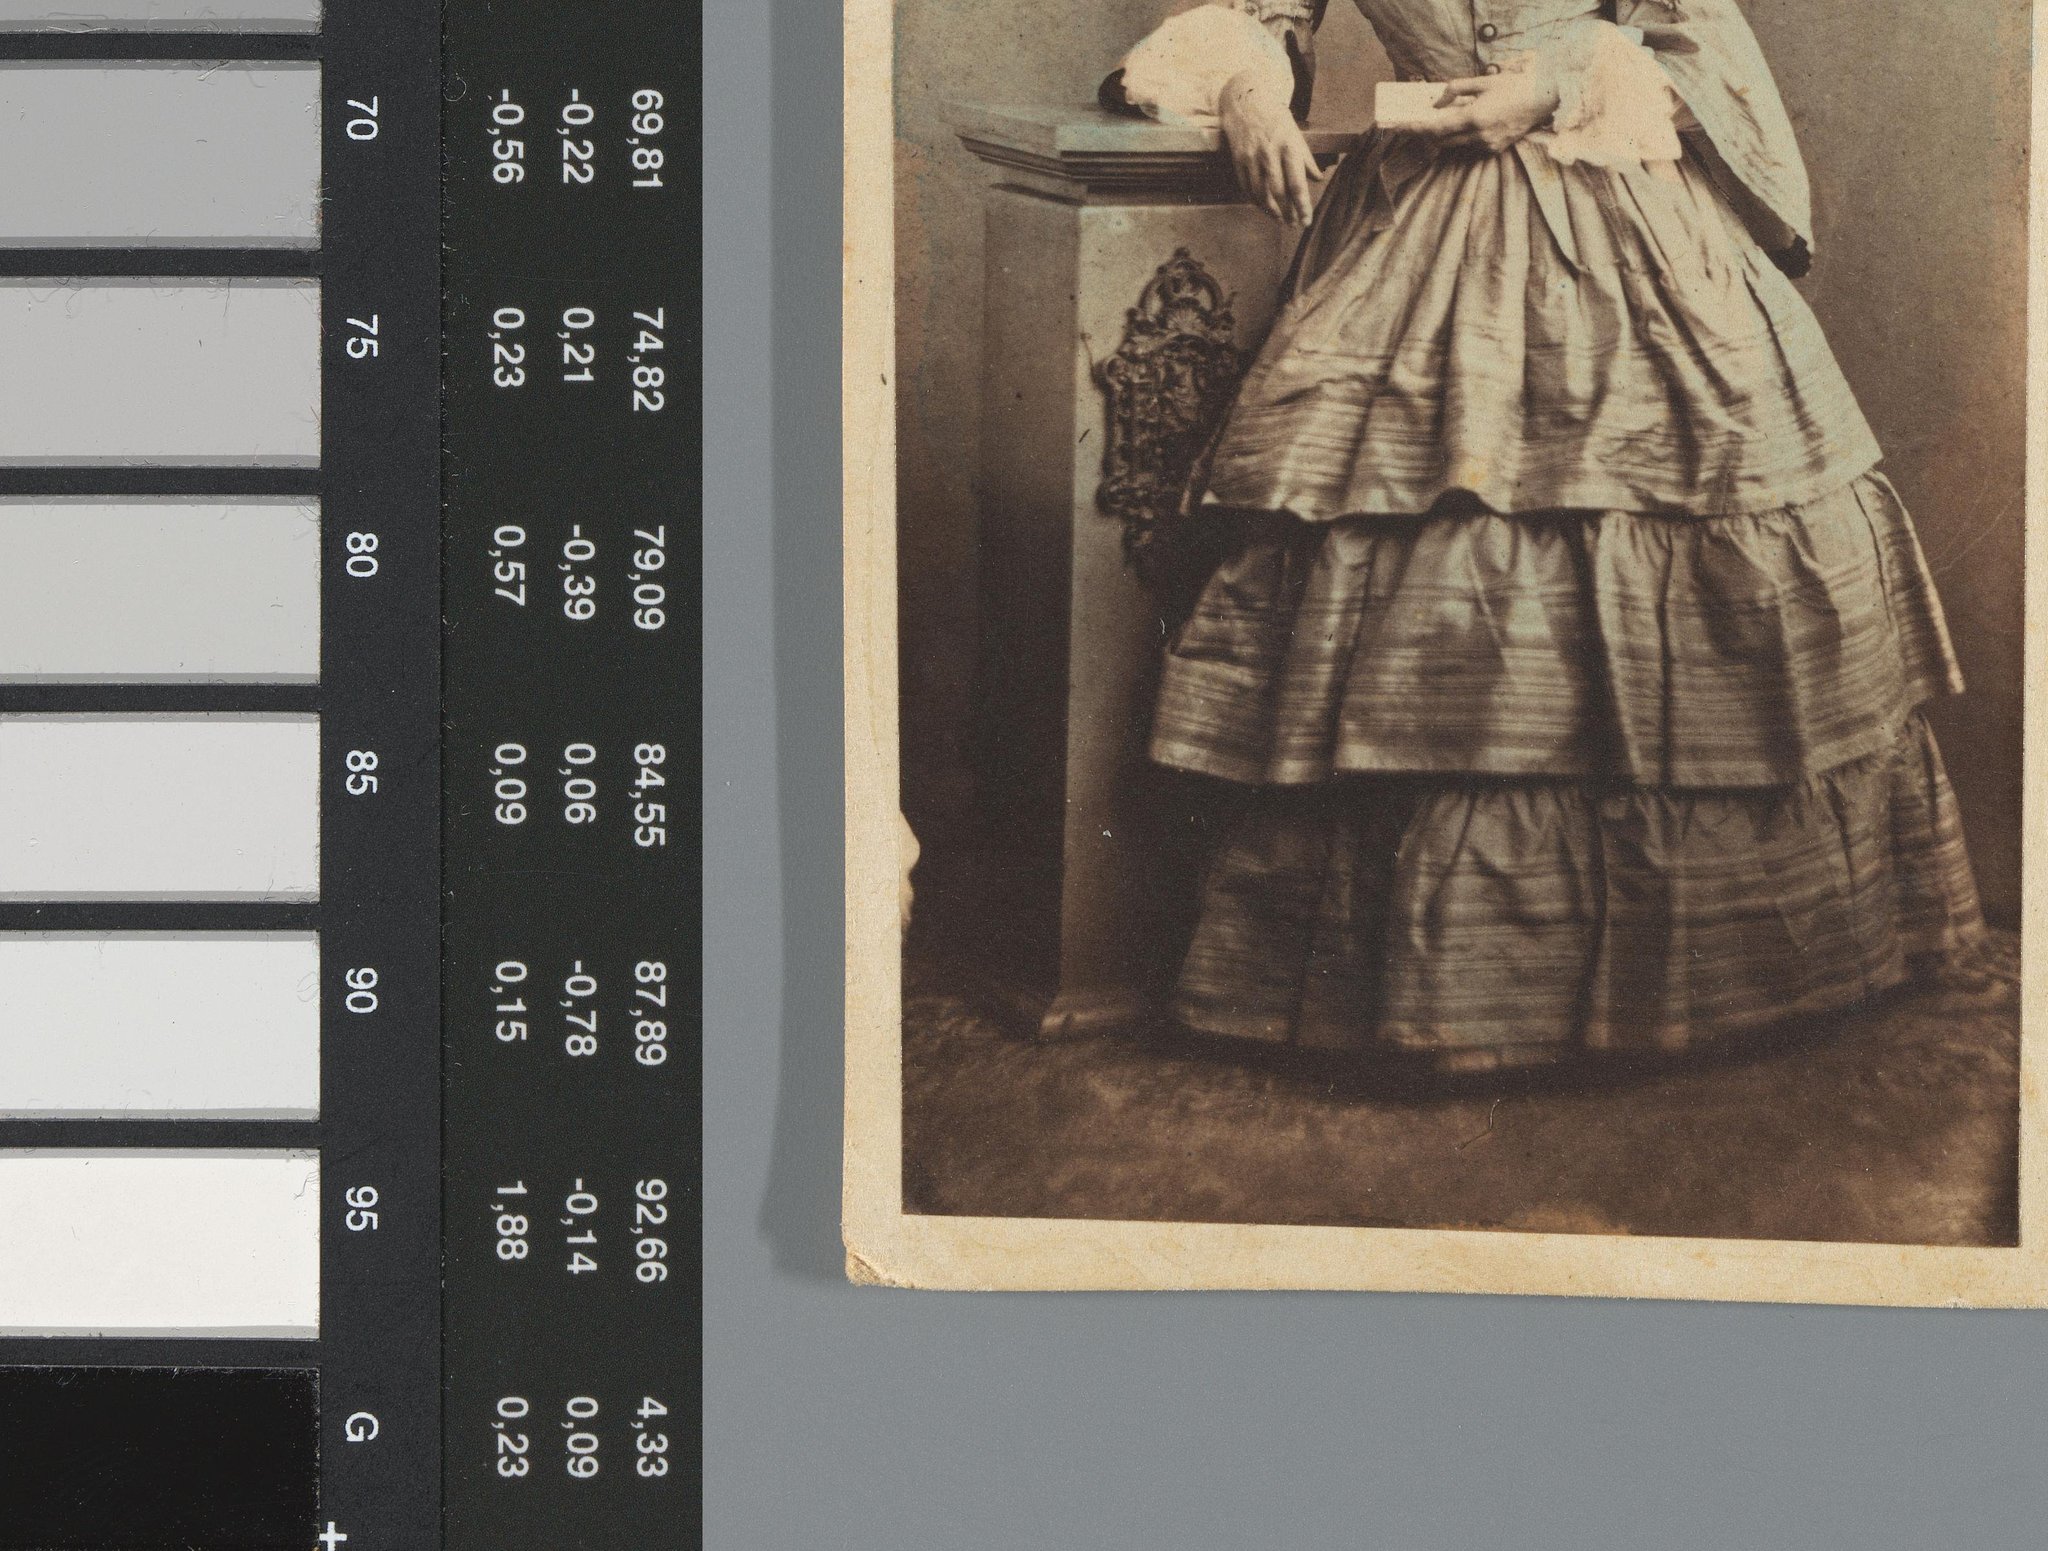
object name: photograph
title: Portret van Cornelia Theresia Carolina van den Berg (Cornelie)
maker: a. böeseken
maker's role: fotograaf, lithograaf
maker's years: 1834-1919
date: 1855-1910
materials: cardboard, photographic support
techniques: albumen print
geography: rotterdam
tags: delft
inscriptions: inscription: ‘Cornelie / van den Berg / 1837 -1907’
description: Staande vrouw ten voeten uit met een brief in de hand leunend op een sokkel.